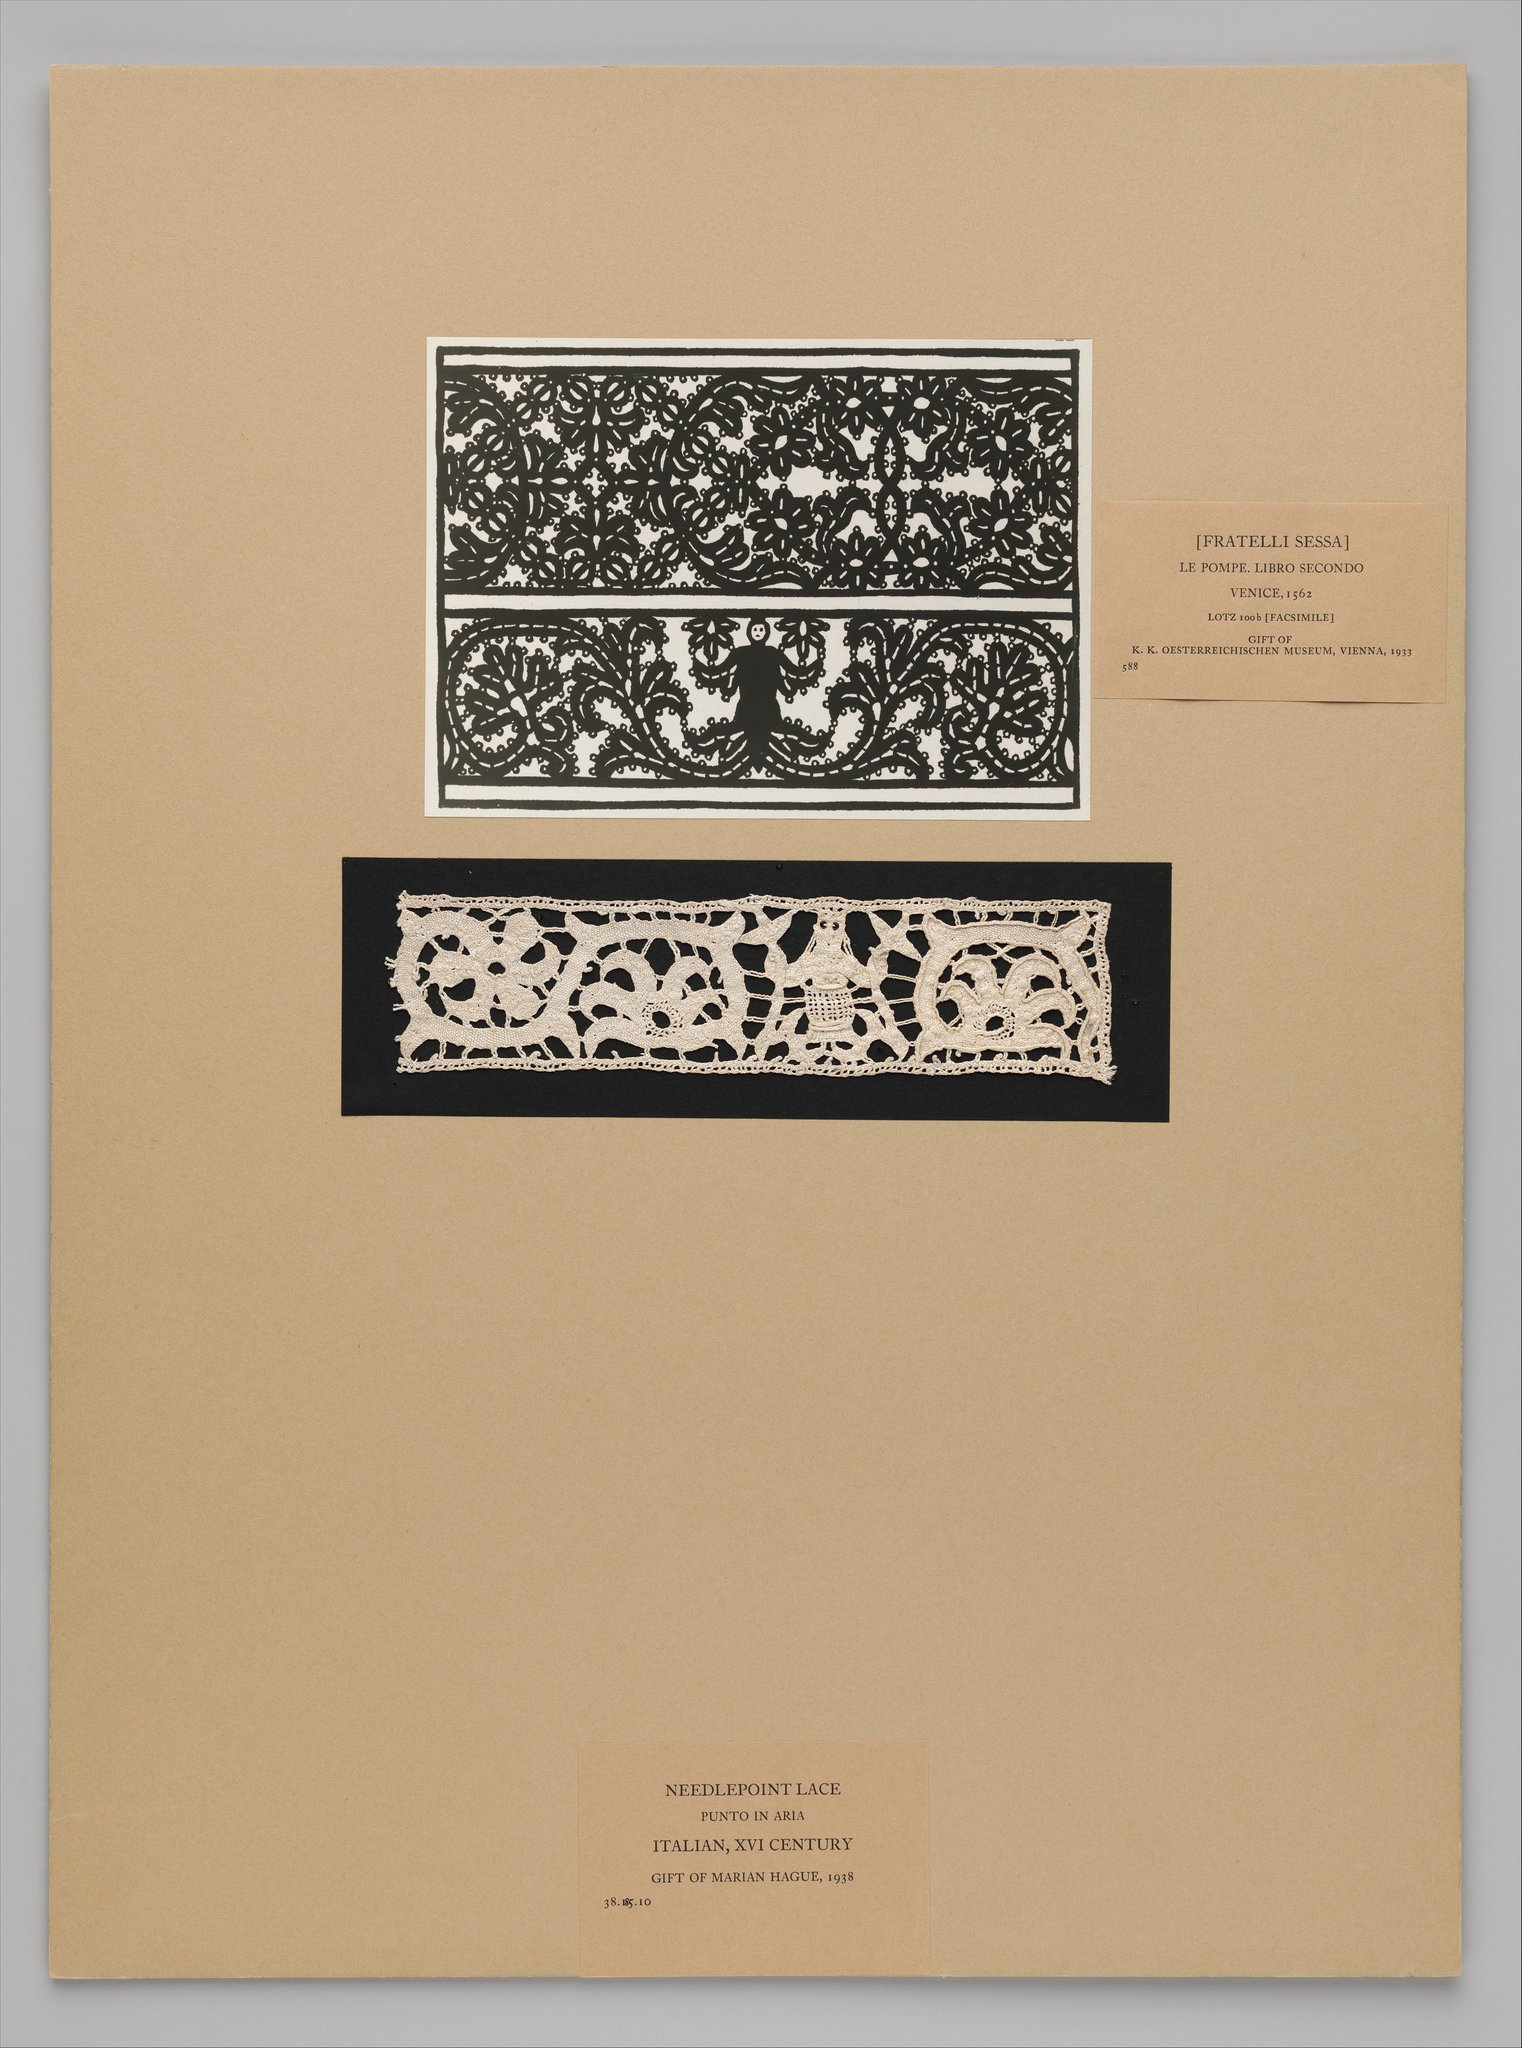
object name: insertion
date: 1501-1600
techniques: lace